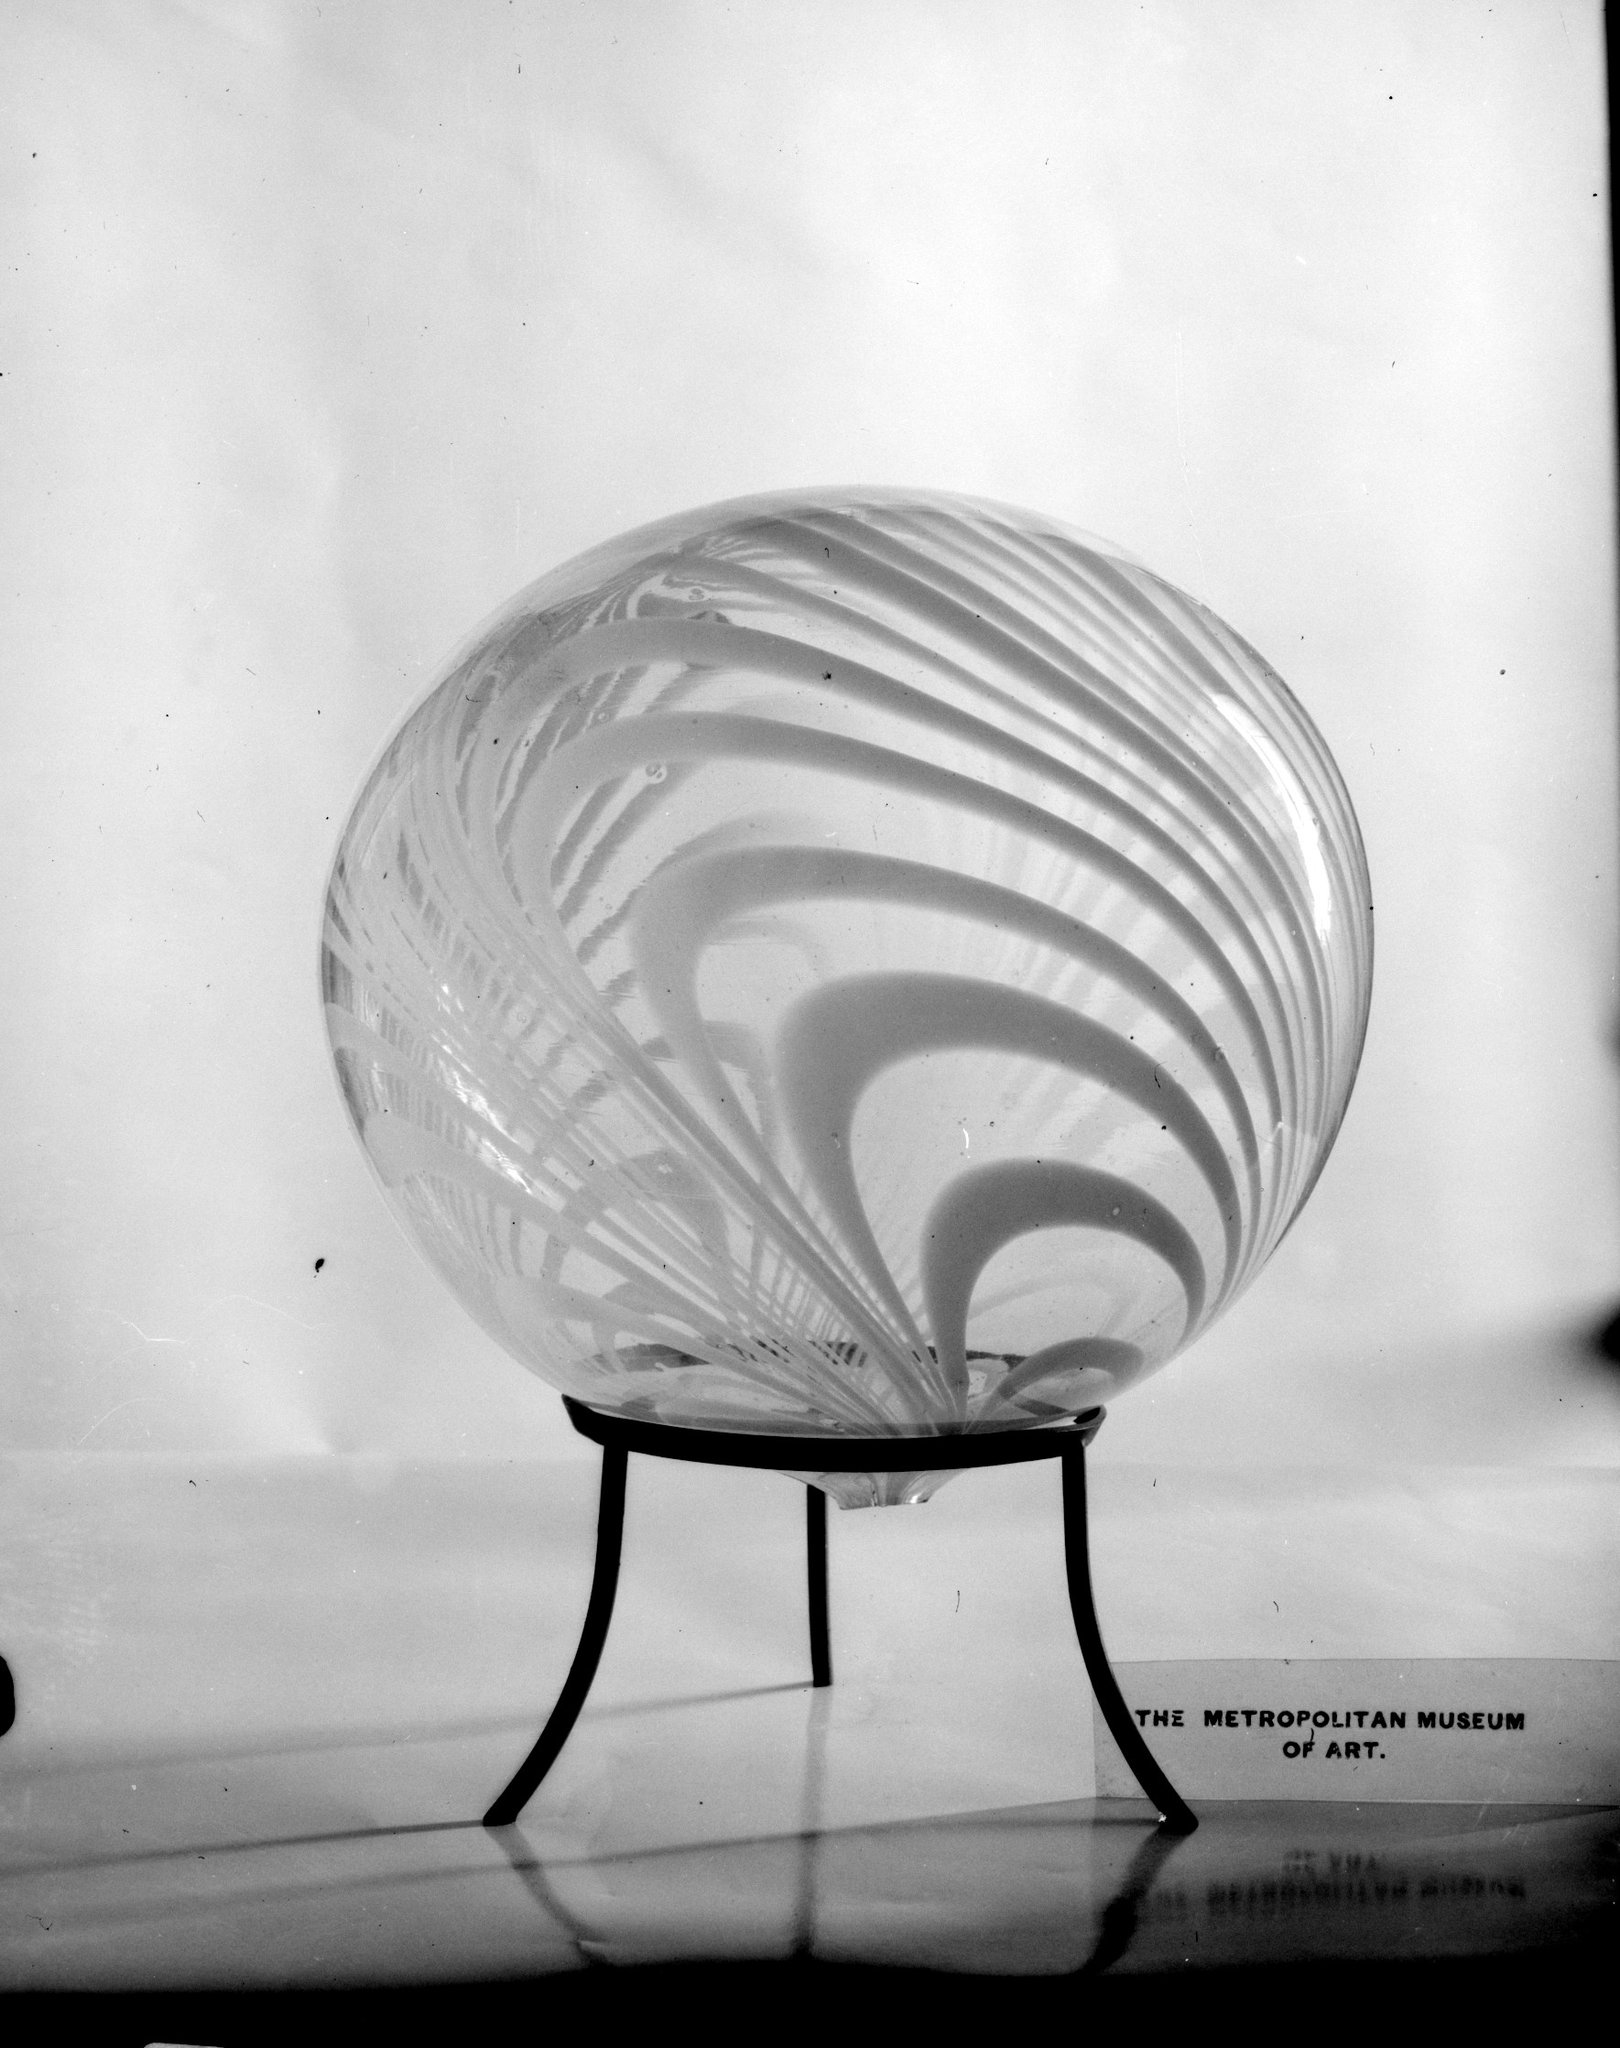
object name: globe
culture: american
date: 1860-1880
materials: glass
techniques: glassblowing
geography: mid-atlantic